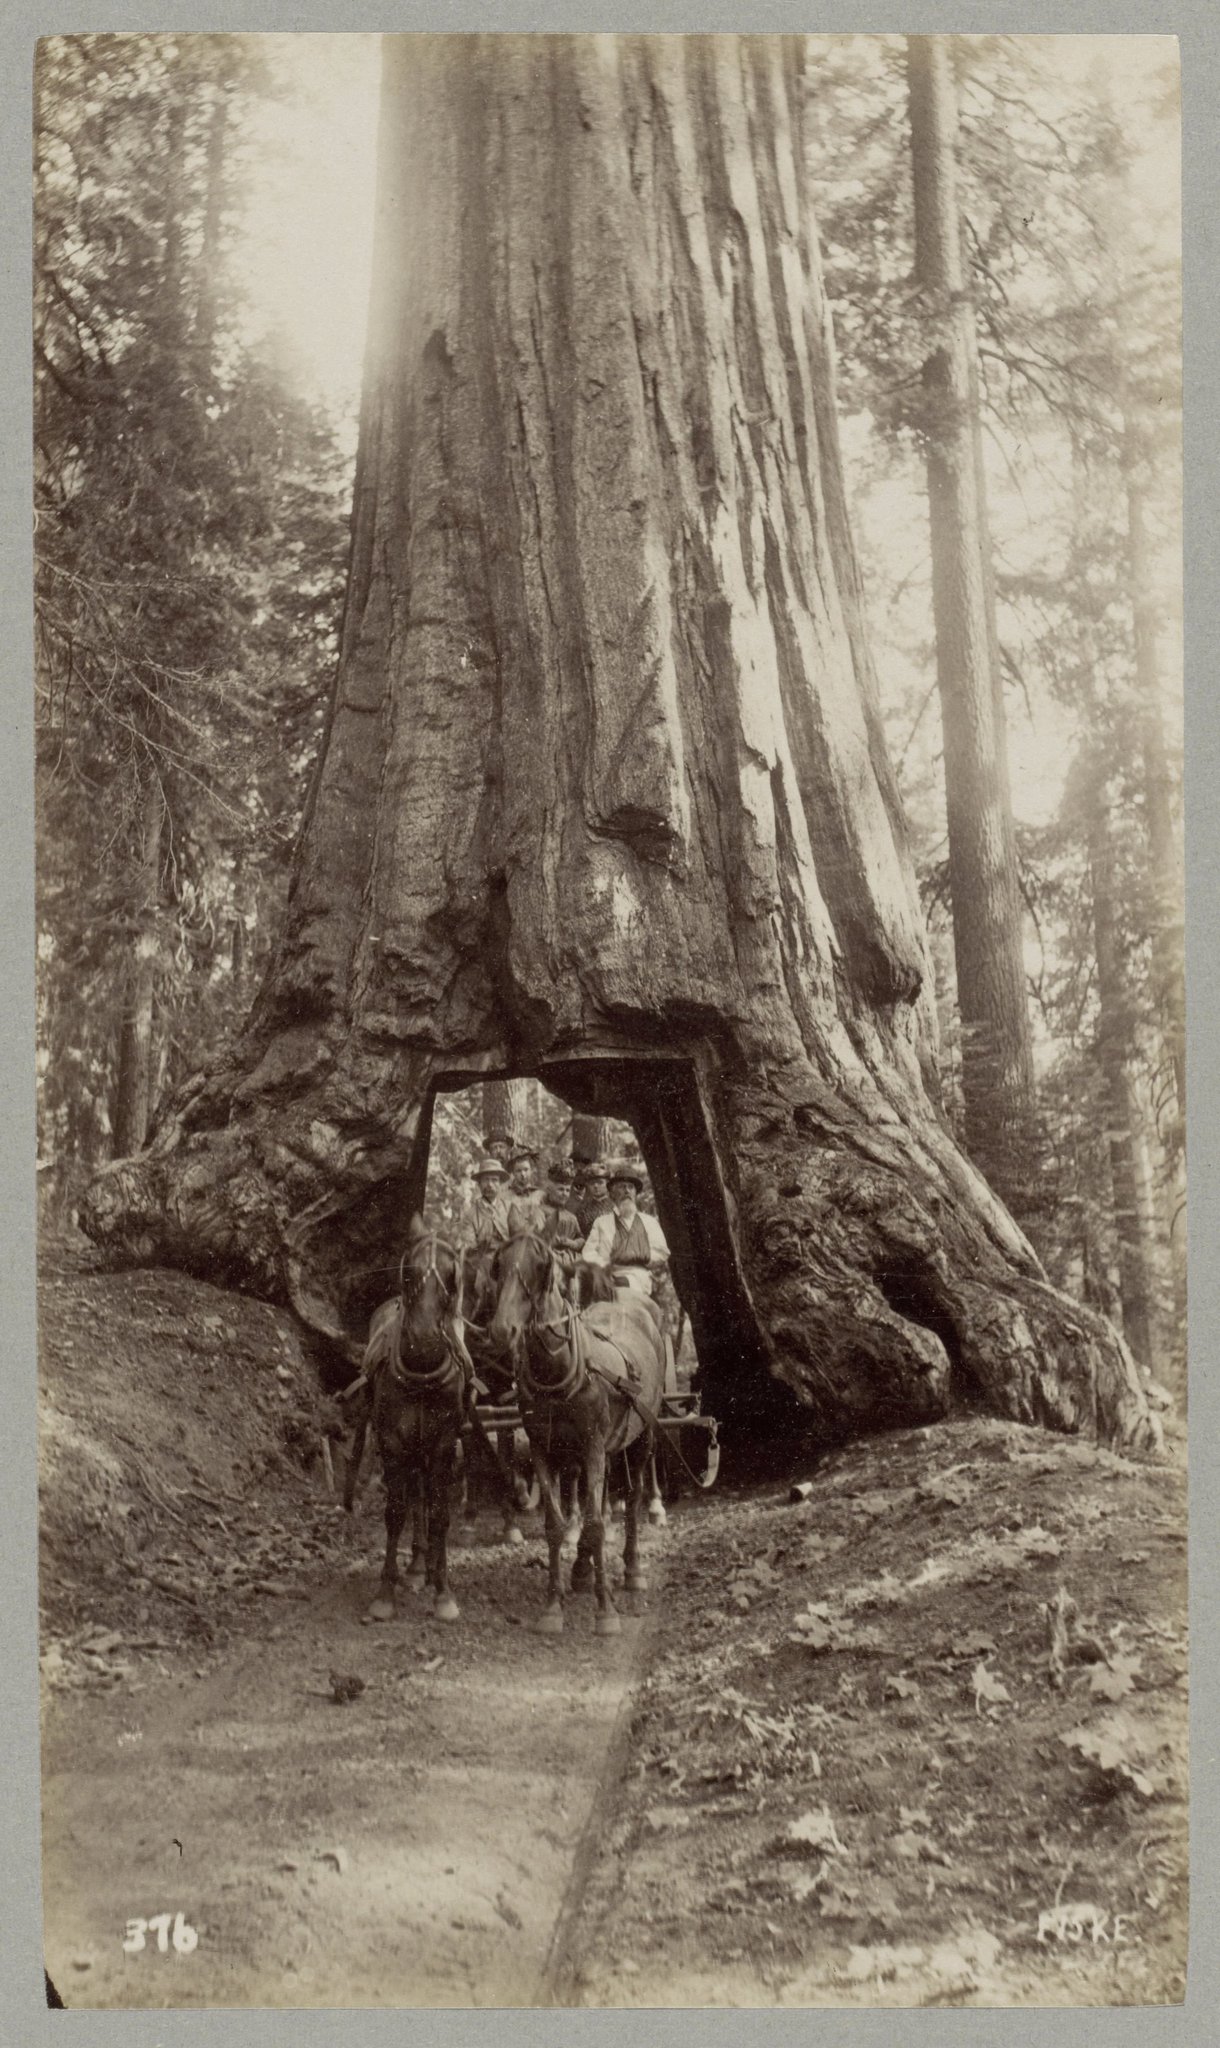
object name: photograph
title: Gezelschap op een paardenkar rijdt door de Wawona-sequoia in het Yosemite National Park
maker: george fiske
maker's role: fotograaf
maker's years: 1835-1918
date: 1880-1900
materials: cardboard, paper, photographic support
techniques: albumen print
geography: yosemite national park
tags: trees: sequoia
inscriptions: negative number: ‘376’